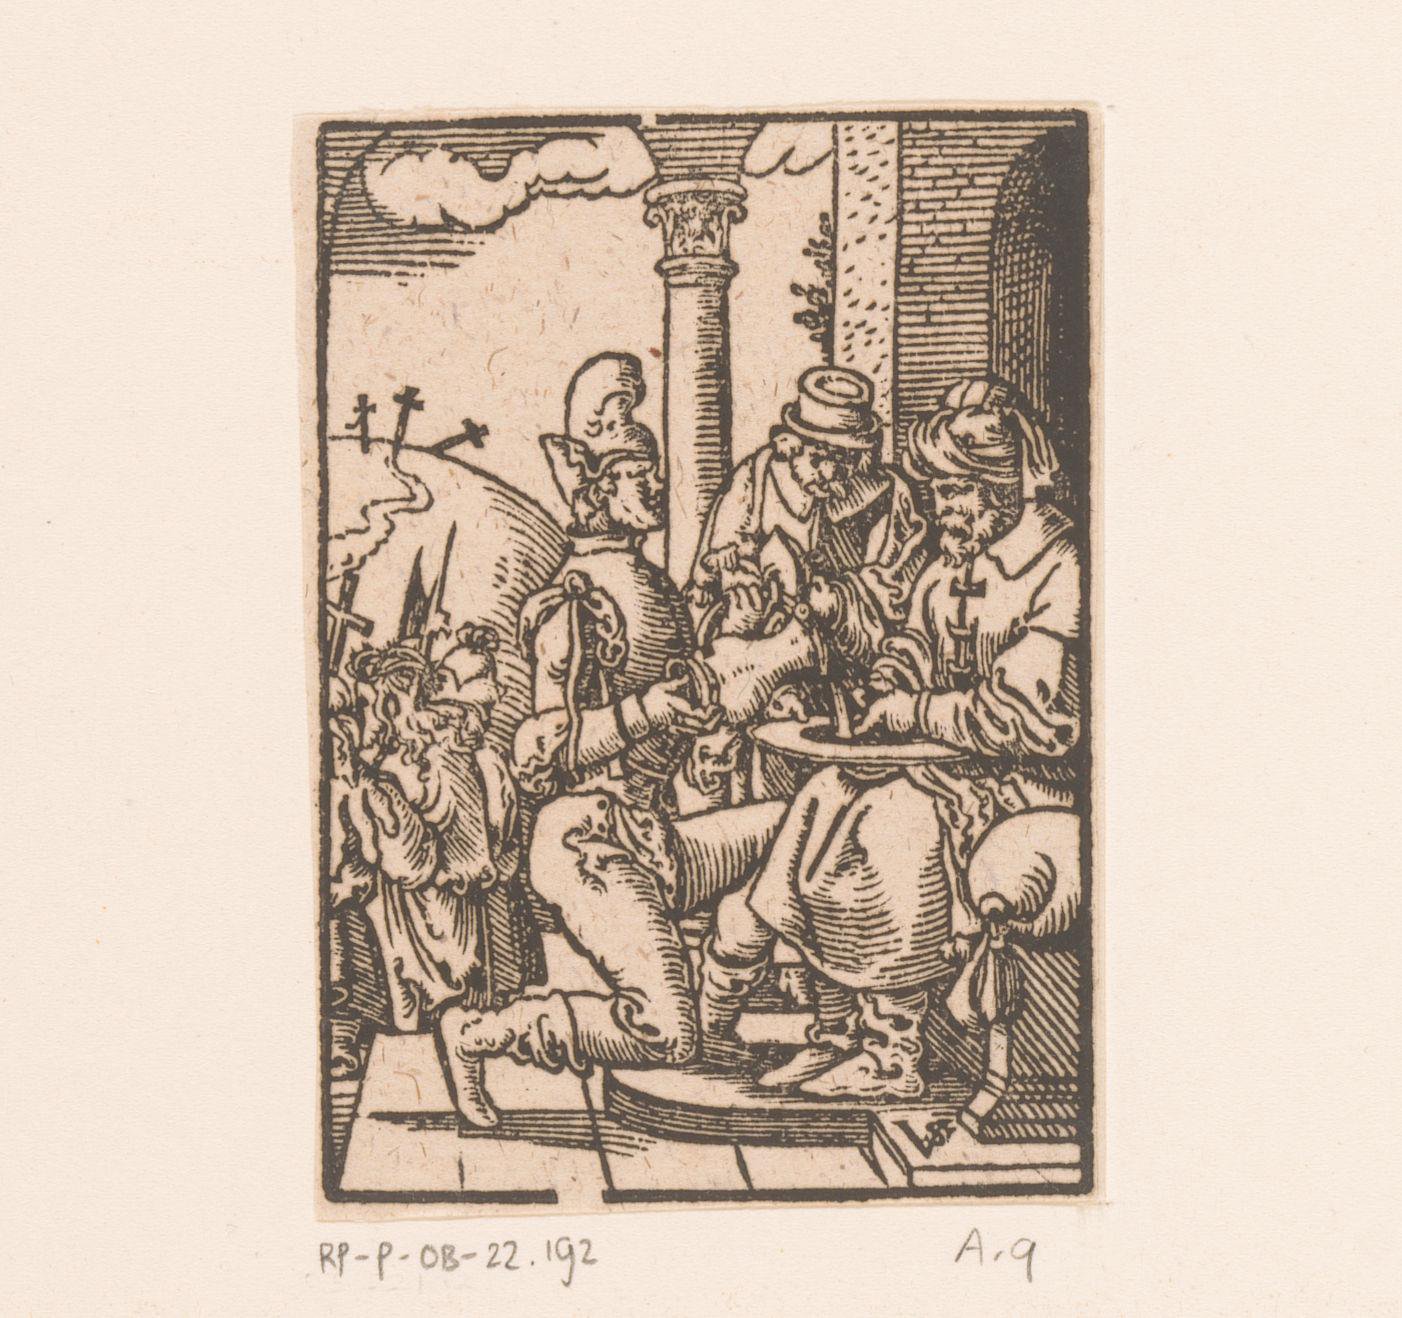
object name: print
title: Pilatus wast zijn handen in onschuld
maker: virgilius solis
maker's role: draughtsman, print maker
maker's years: 1514-1562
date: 1558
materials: paper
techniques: woodcut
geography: nuremberg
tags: pilate washing his hands (in innocence)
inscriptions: number: ‘180’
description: Gebruikt voor de publicatie: Rhau, Georg. Hortulus Animae. Neurenberg: Valentin Geißler, 1558.